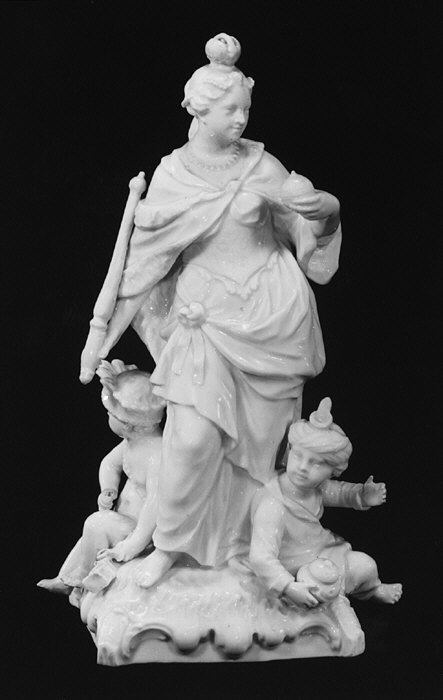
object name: group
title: Four continents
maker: royal porcelain manufactory, berlin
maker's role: manufactory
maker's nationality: german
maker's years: 1763-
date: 1769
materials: soft paste porcelain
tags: children,women